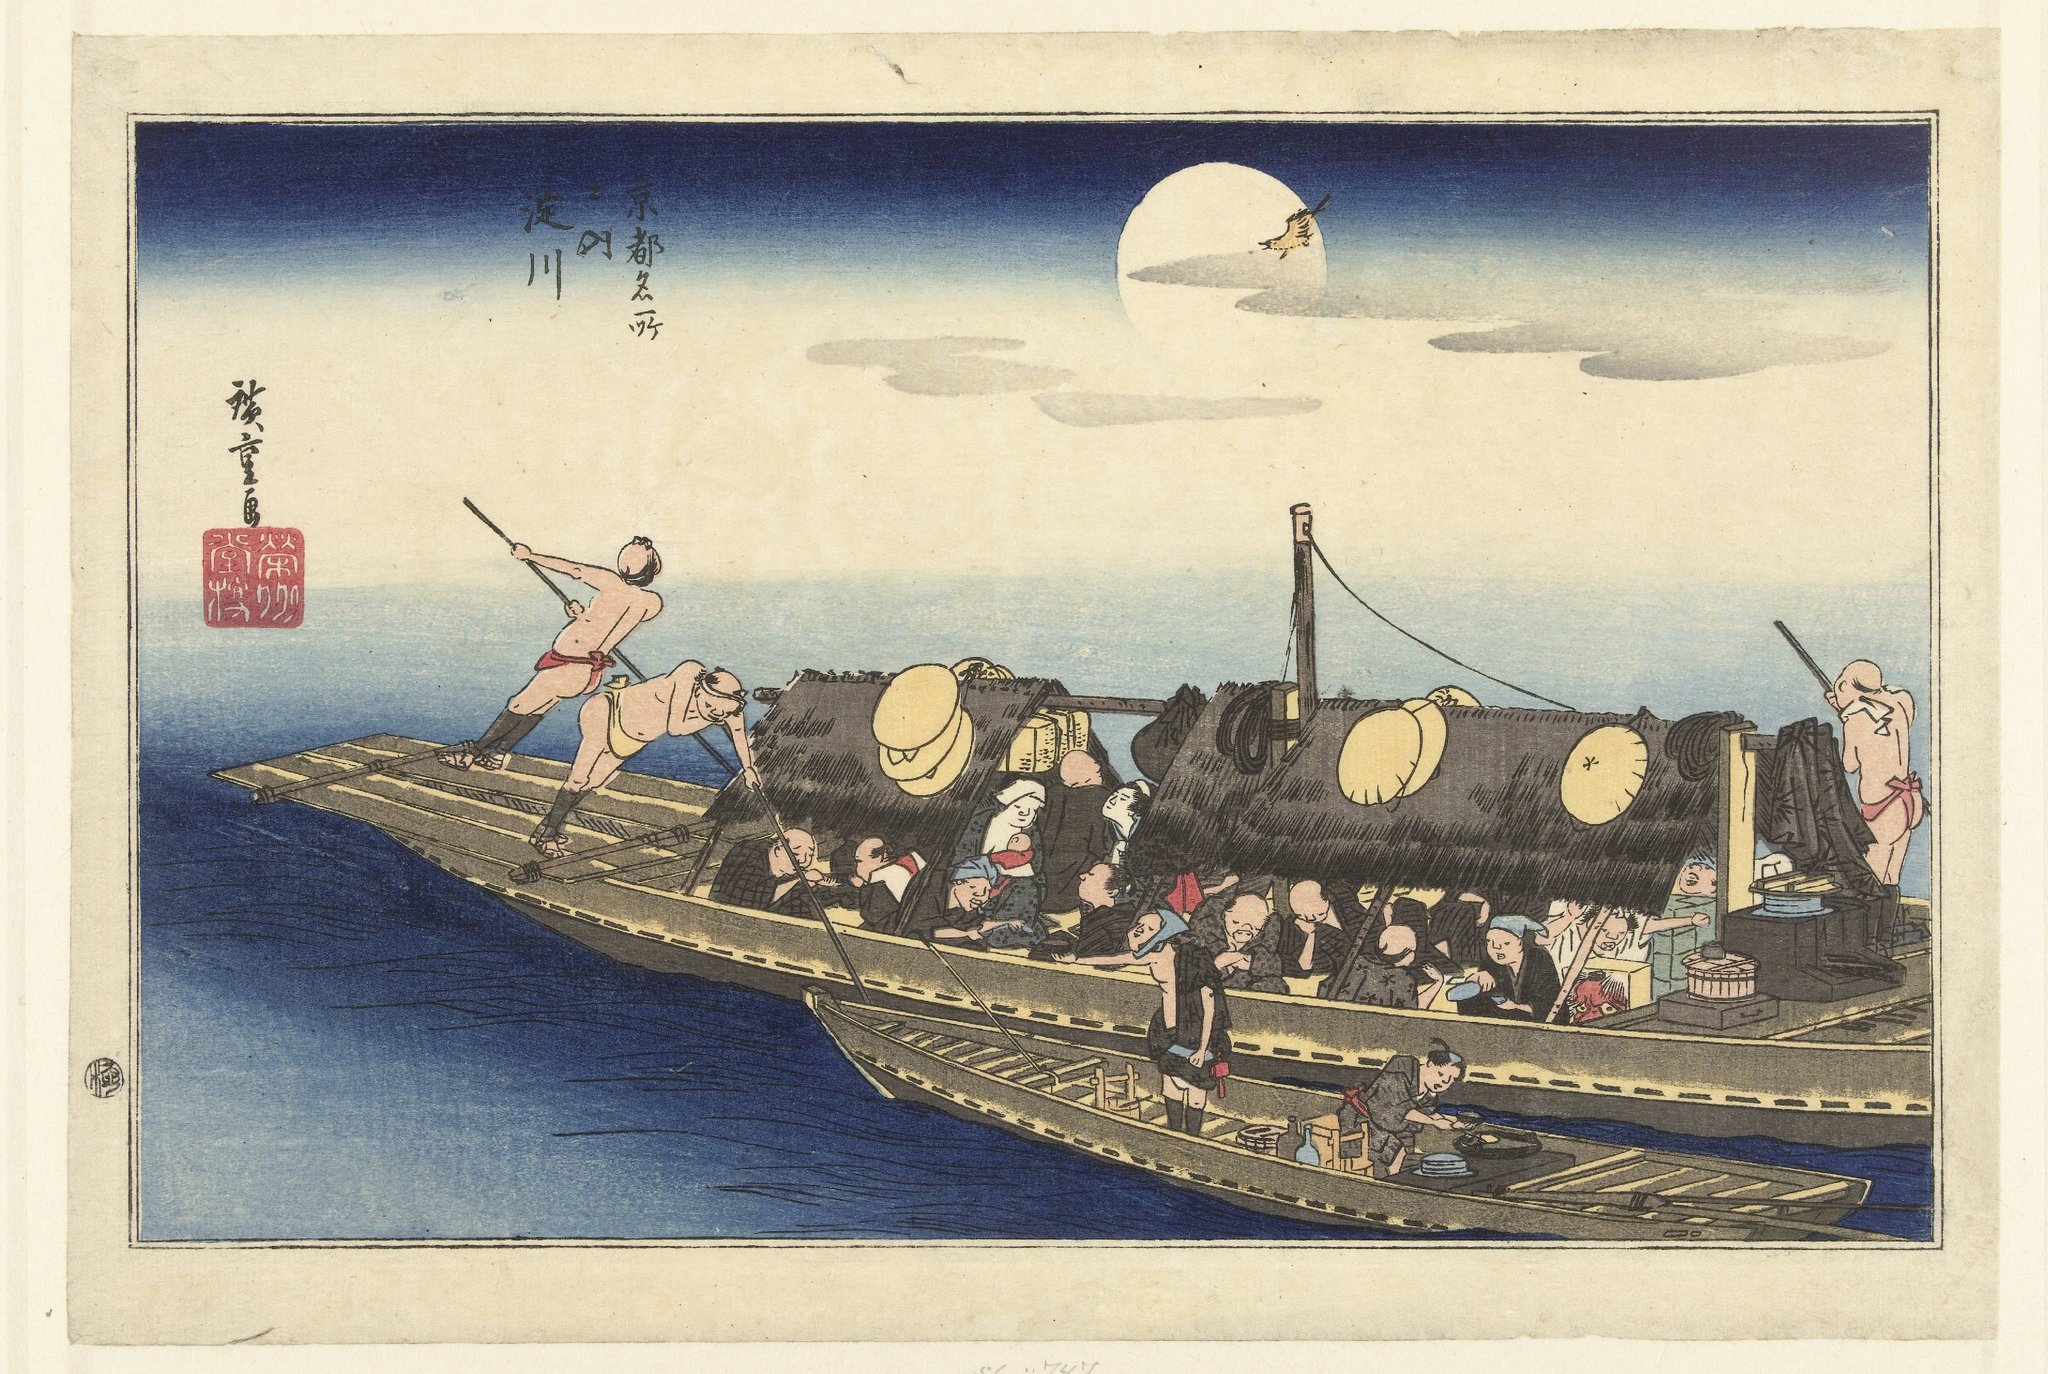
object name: print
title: De Yodo rivier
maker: utagawa hiroshige (i)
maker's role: draughtsman, print maker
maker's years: 1797-1858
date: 1833-1837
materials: paper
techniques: woodcut, nishiki e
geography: japan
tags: crew and passengers ~ ship, boat propelled by man or animal, japan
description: Een veerboot, pasagiers vervoerend over de Yodo rivier, terwijl een kleinere boot aanhaakt om warme produkten aan de opvarenden te verkopen; twee roeiers opkijkend naar de koekoek vliegend voor de volle maan.